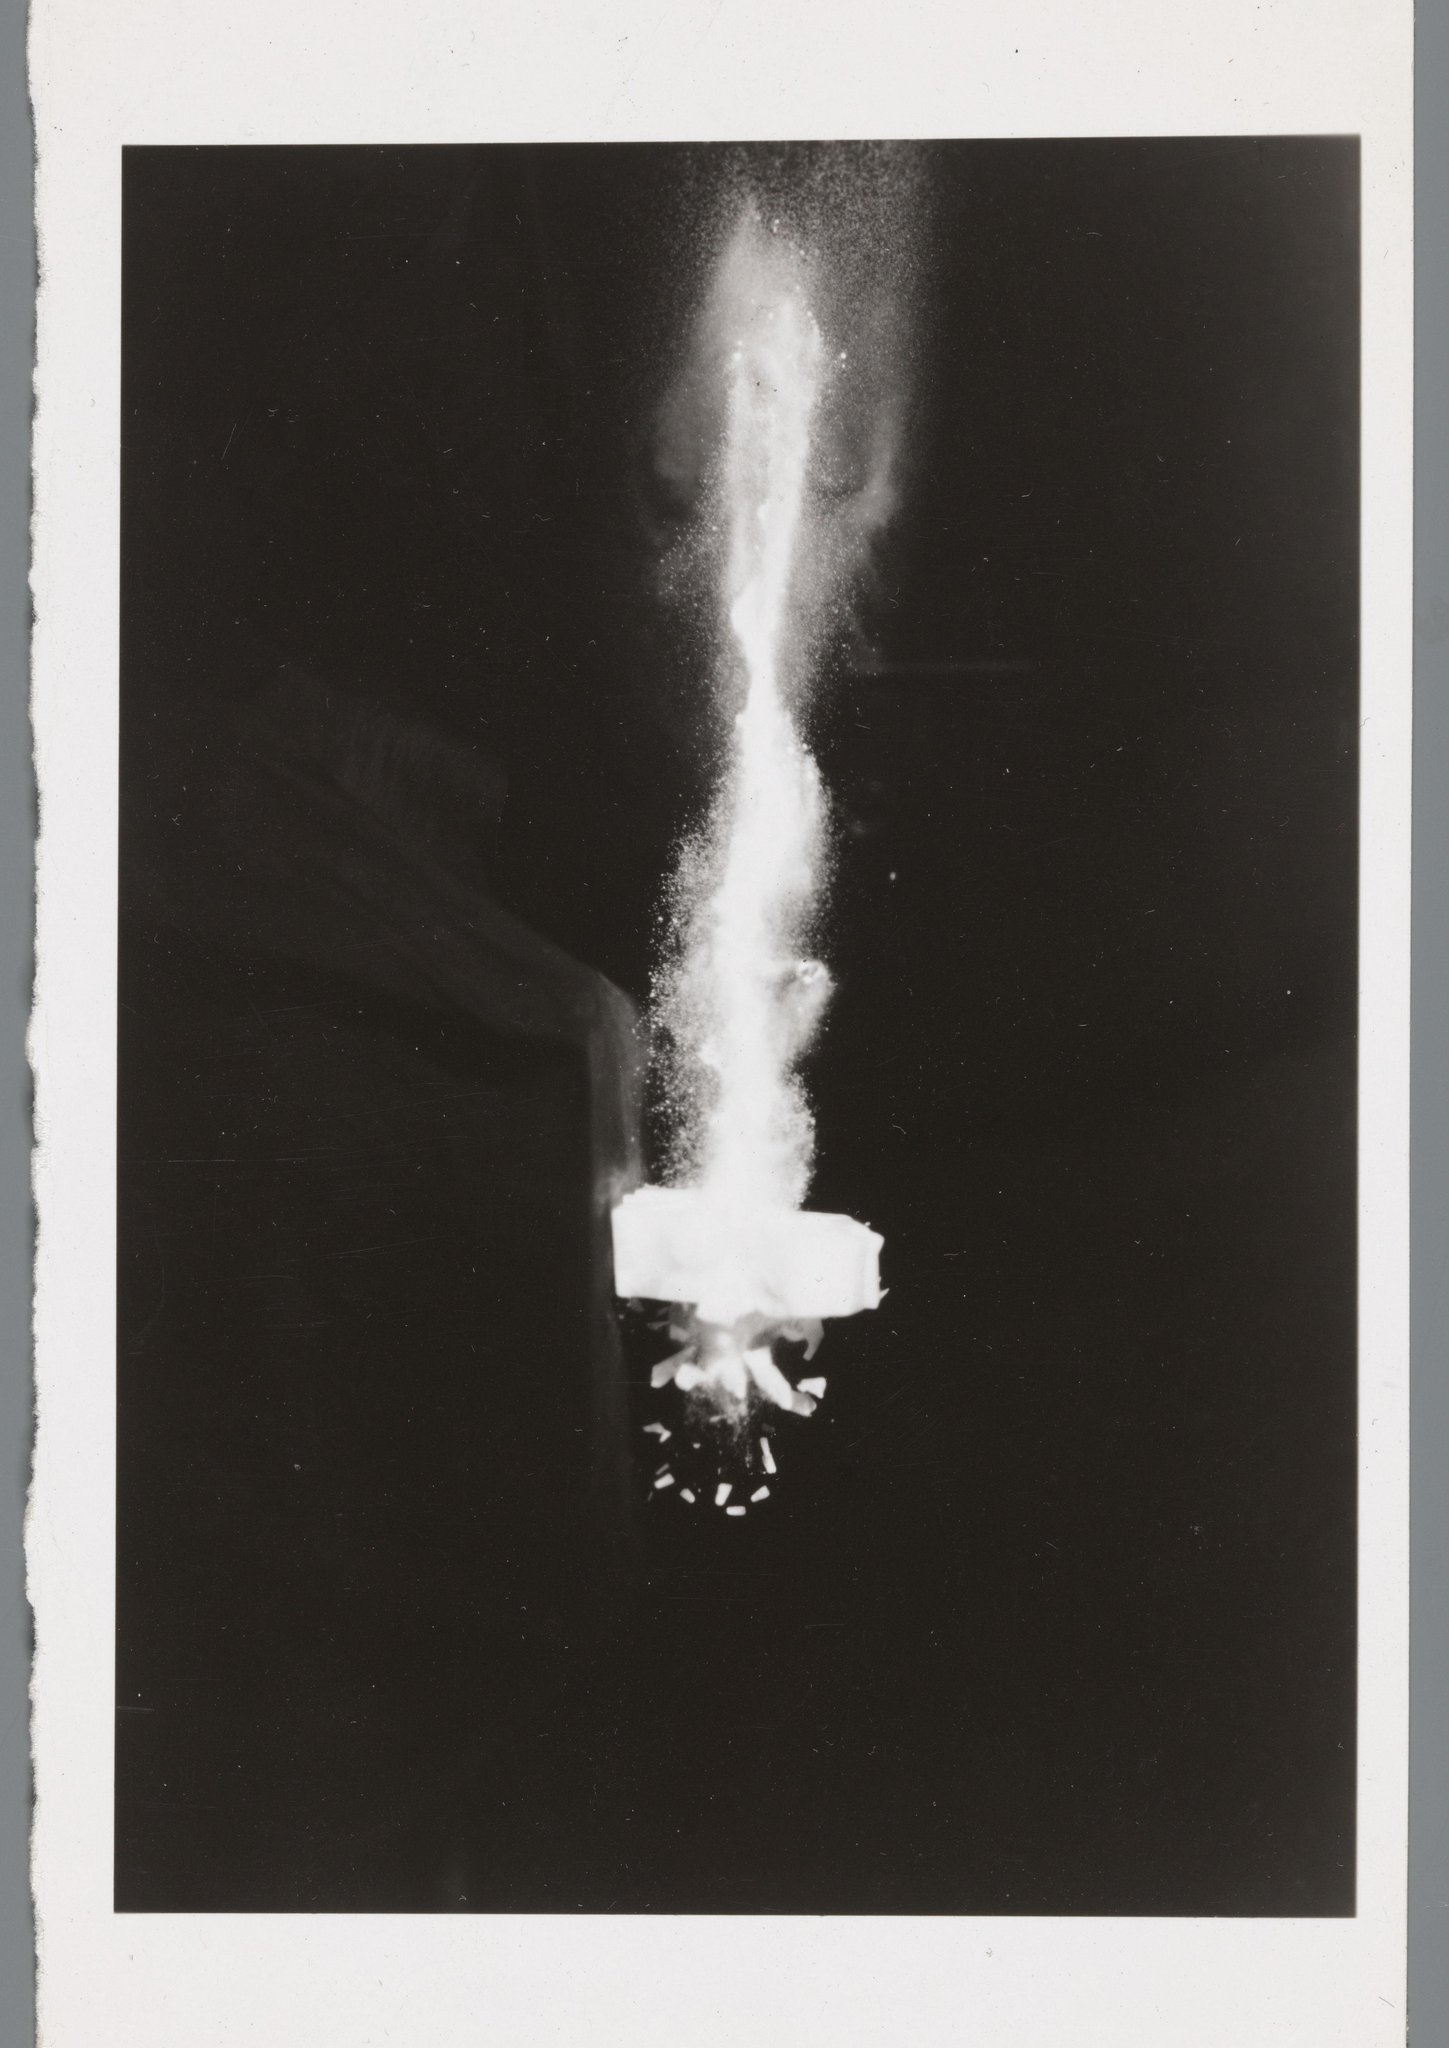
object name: photograph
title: Bullet hits ice cube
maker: Anonymous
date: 1945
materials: paper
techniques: gelatin silver print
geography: united states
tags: invention, discovery ~ science and technology, experiment, test ~ science and technology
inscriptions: stamp: ‘REF. DEPT./ 1-9-45/ N.E.A.’, inscription: ‘Bullett’, inscription: ‘17aa3’, title: ‘Bullet hits ice cube’